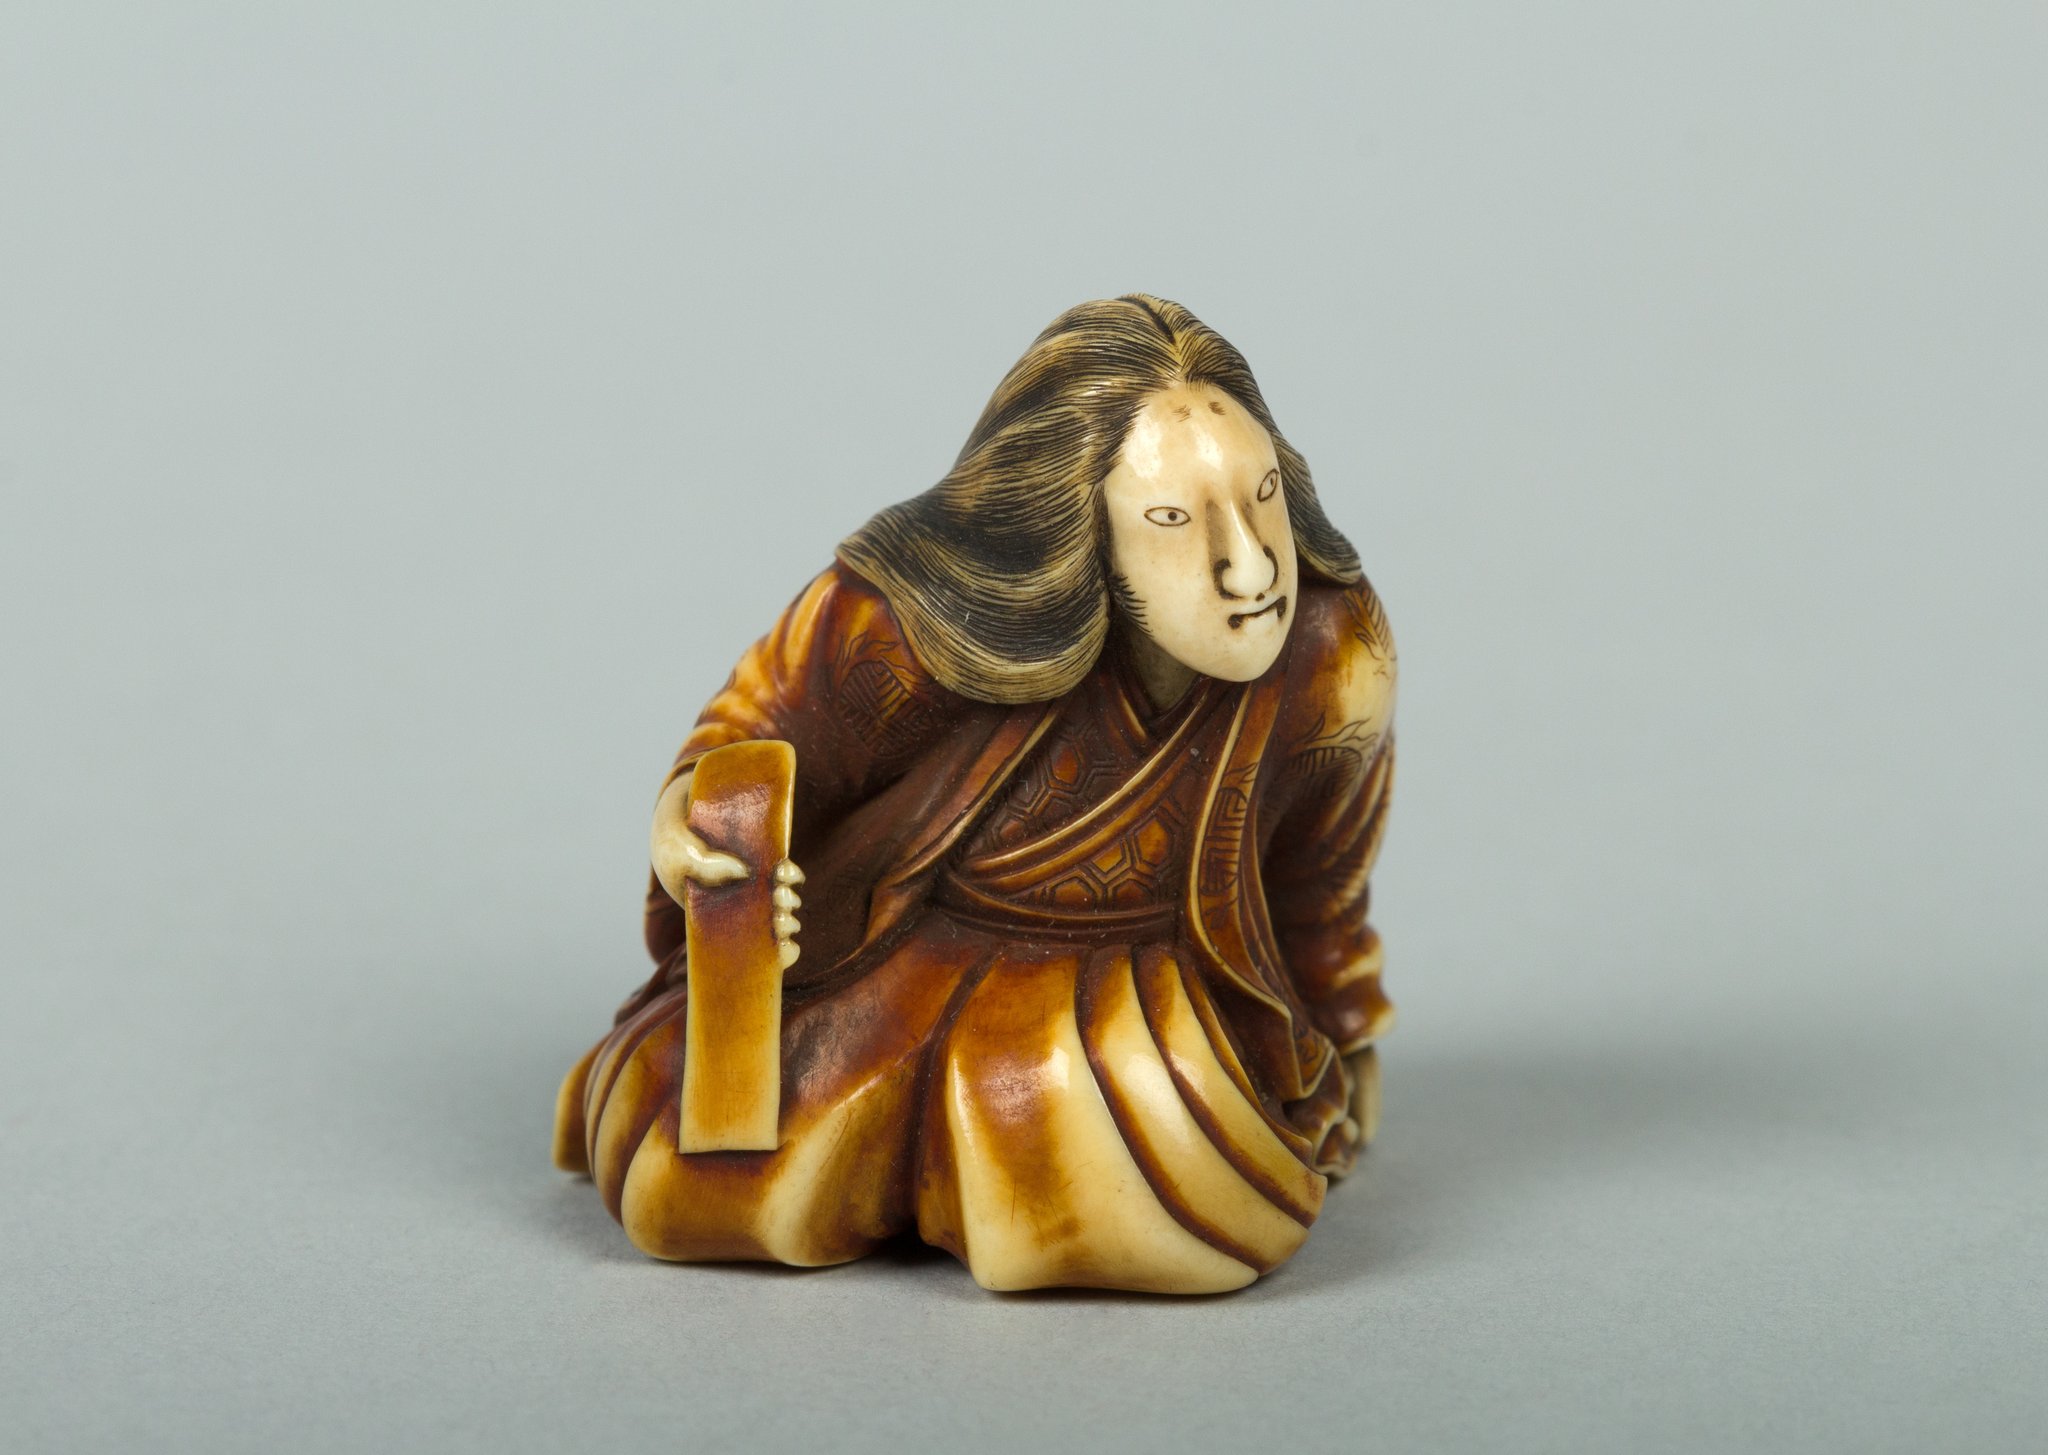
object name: netsuke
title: Netsuke of a Woman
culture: japanese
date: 1801-1900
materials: ivory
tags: women